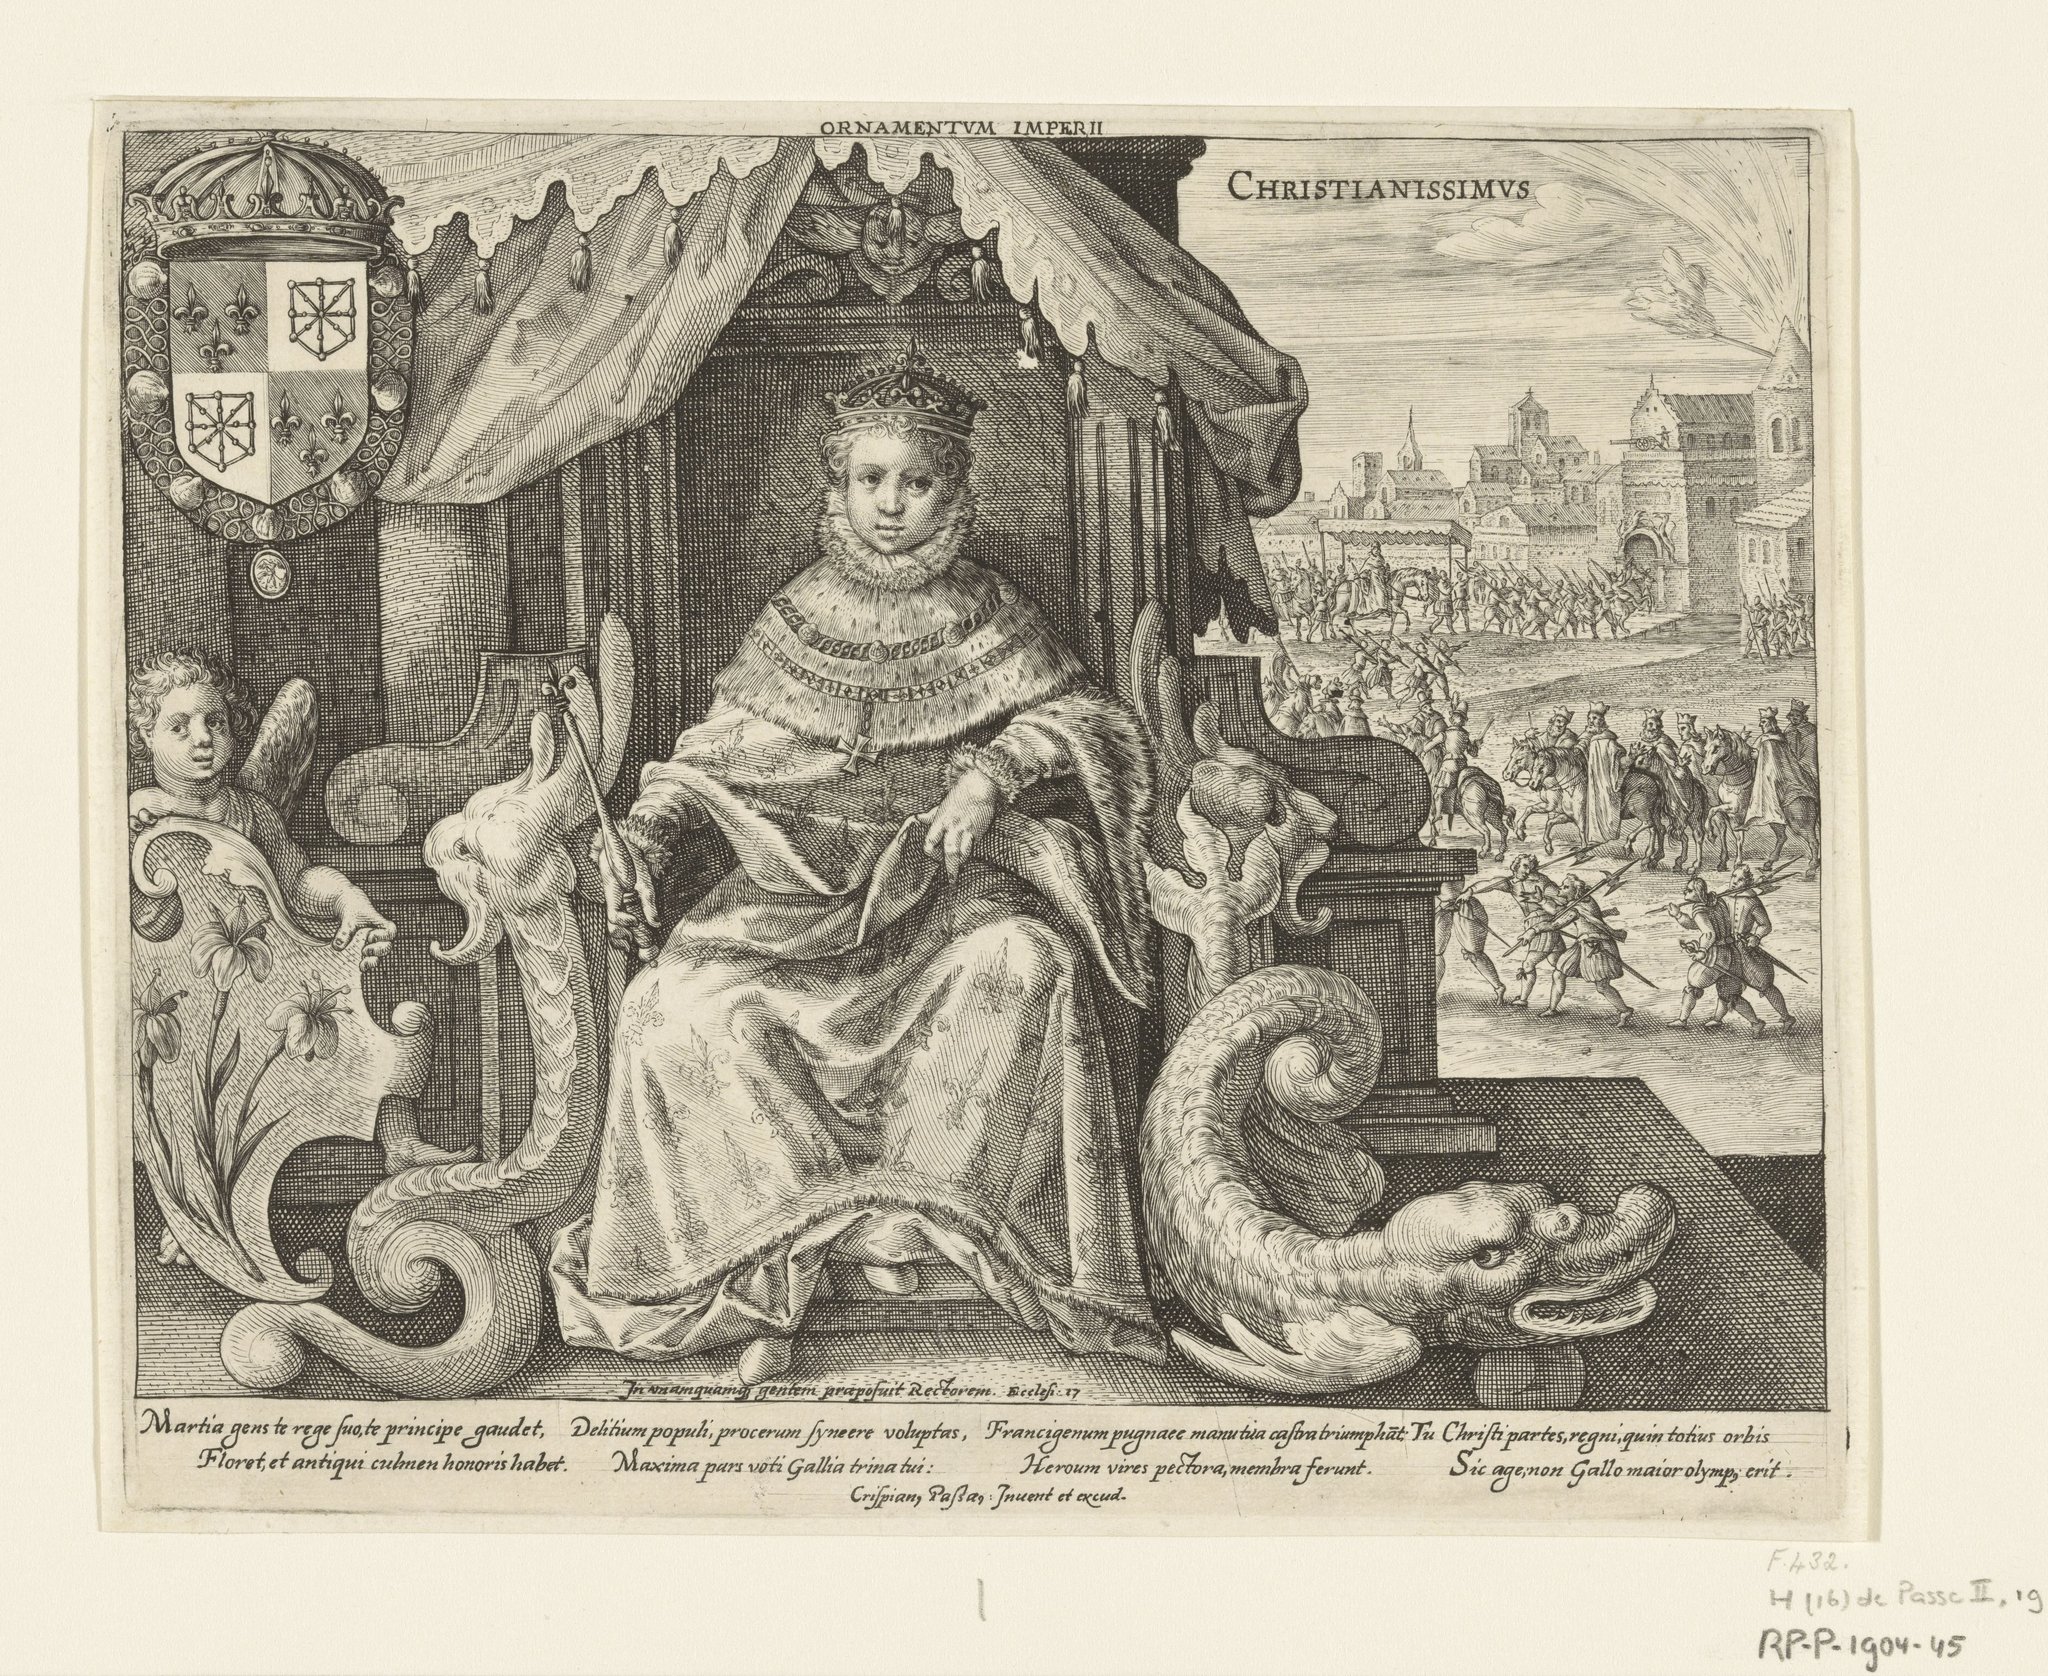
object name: print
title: Christianissimvs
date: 1611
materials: paper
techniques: engraving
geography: utrecht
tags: lodewijk xiii (koning van frankrijk), sceptre, staff (symbol of sovereignty), triumphal entry and public reception, pageant, 'entrée solennelle', 'joyeuse entrée', throne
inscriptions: collector's mark: Lugt 2542, collector's mark: Lugt 2228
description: Lodewijk XIII als kind op een troon. In zijn rechterhand houdt hij een scepter. Linksboven zijn wapenschild. Naast de troon staat een engel met een wapenschild met drie lelies. Op de achtergrond de feestelijke intocht van Lodewijk XIII. Midden onder een Bijbelcitaat uit Pr. 17 in het Latijn. In de marge een achtregelig lofdicht, in vier kolommen, in het Latijn. Derde prent uit een serie van vier met wereldheersers.